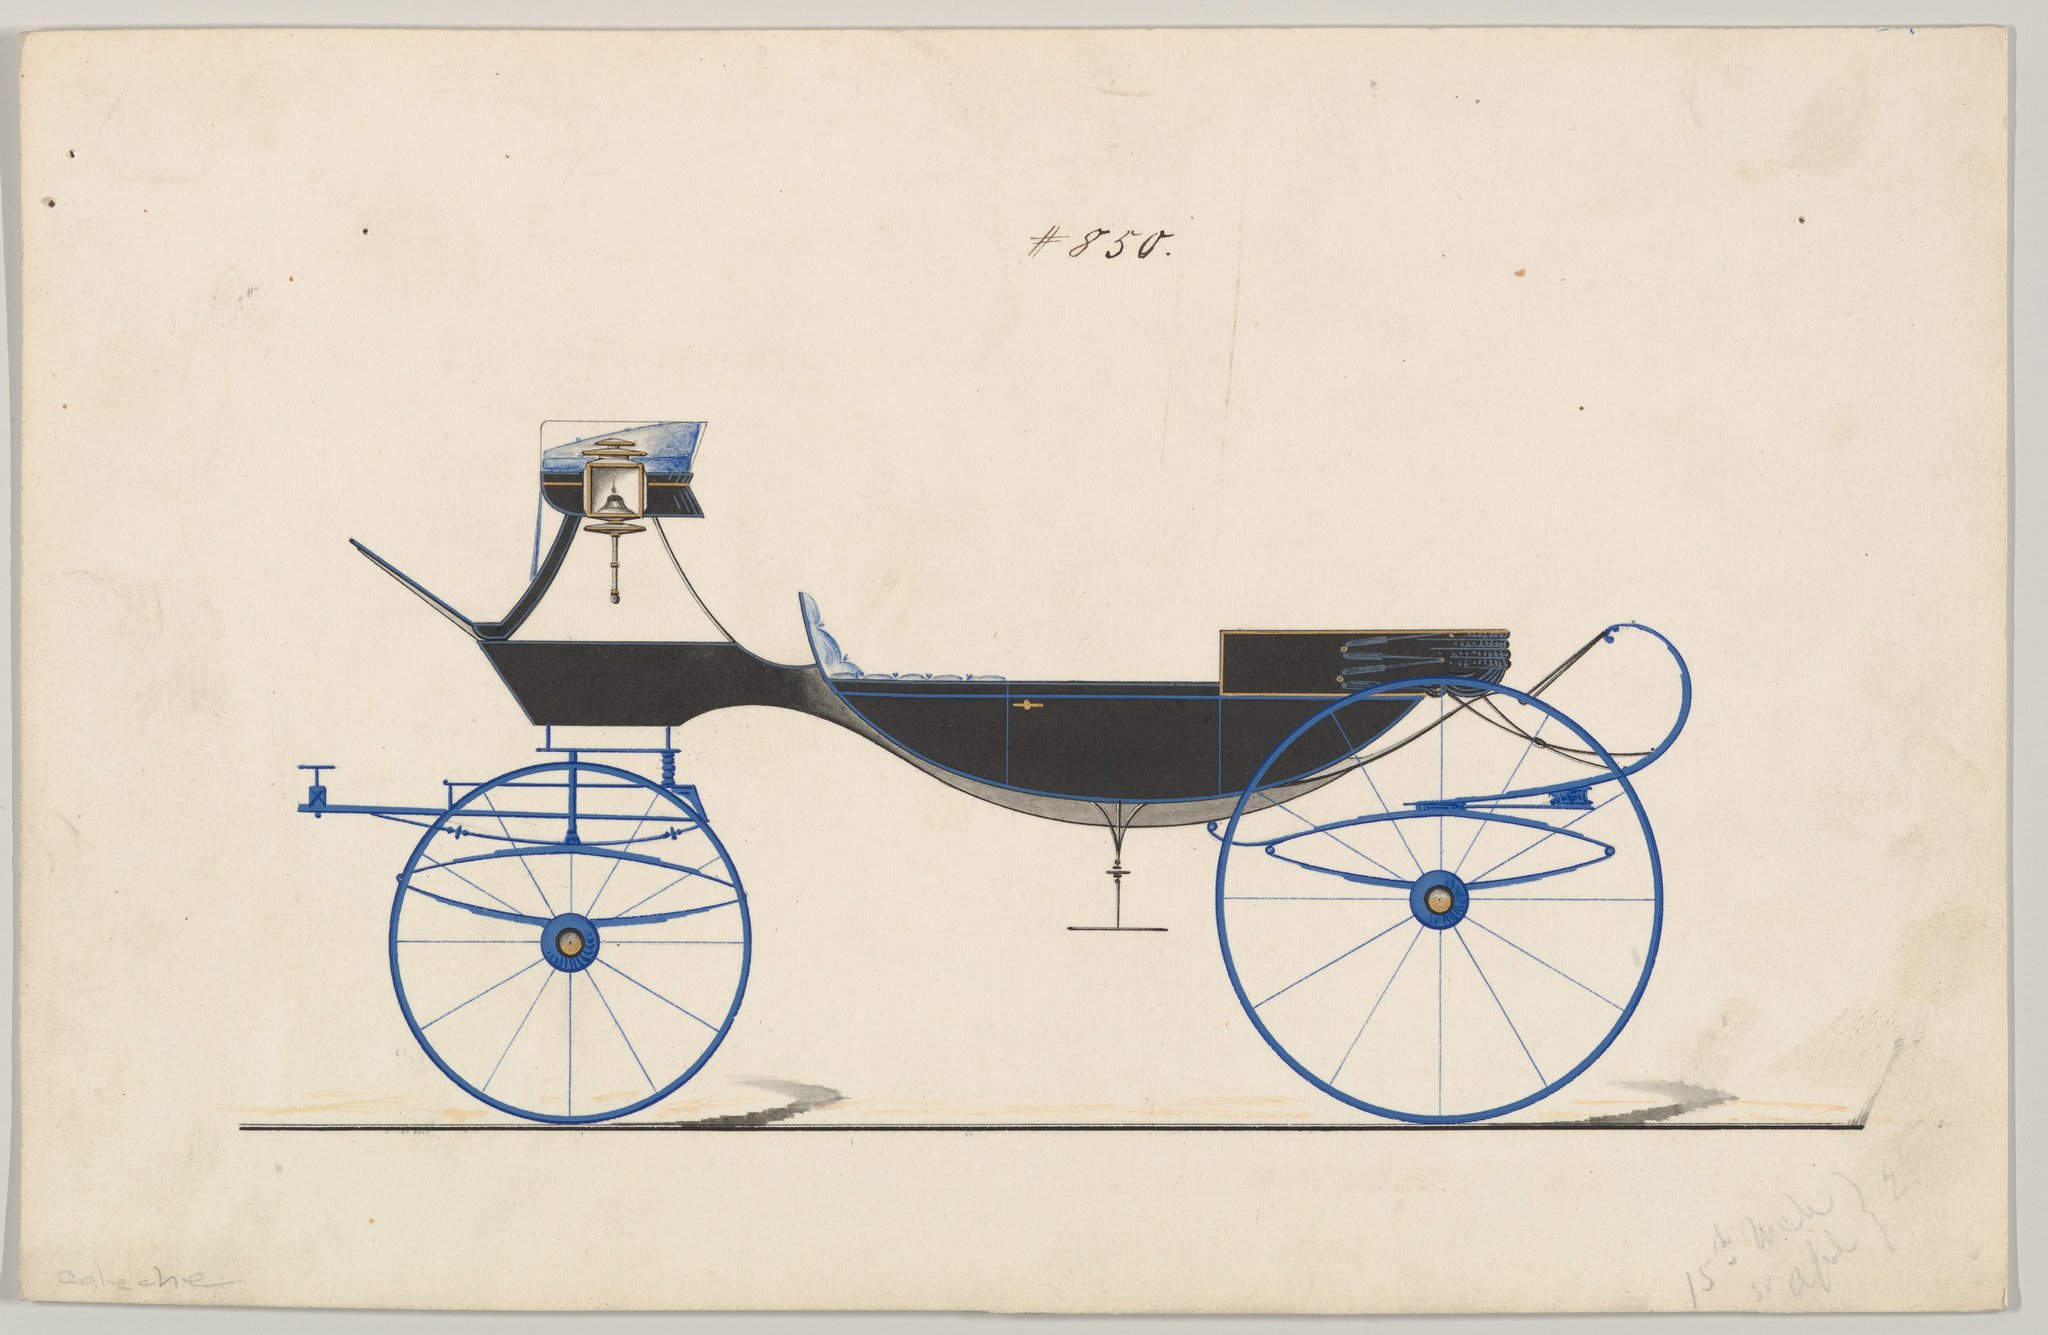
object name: drawing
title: Design for Vis-à-vis/ Caleche, no. 850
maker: brewster & co.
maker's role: manufacturer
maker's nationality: american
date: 1850-1870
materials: gouache, graphite, ink, watercolor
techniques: pen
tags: carriages